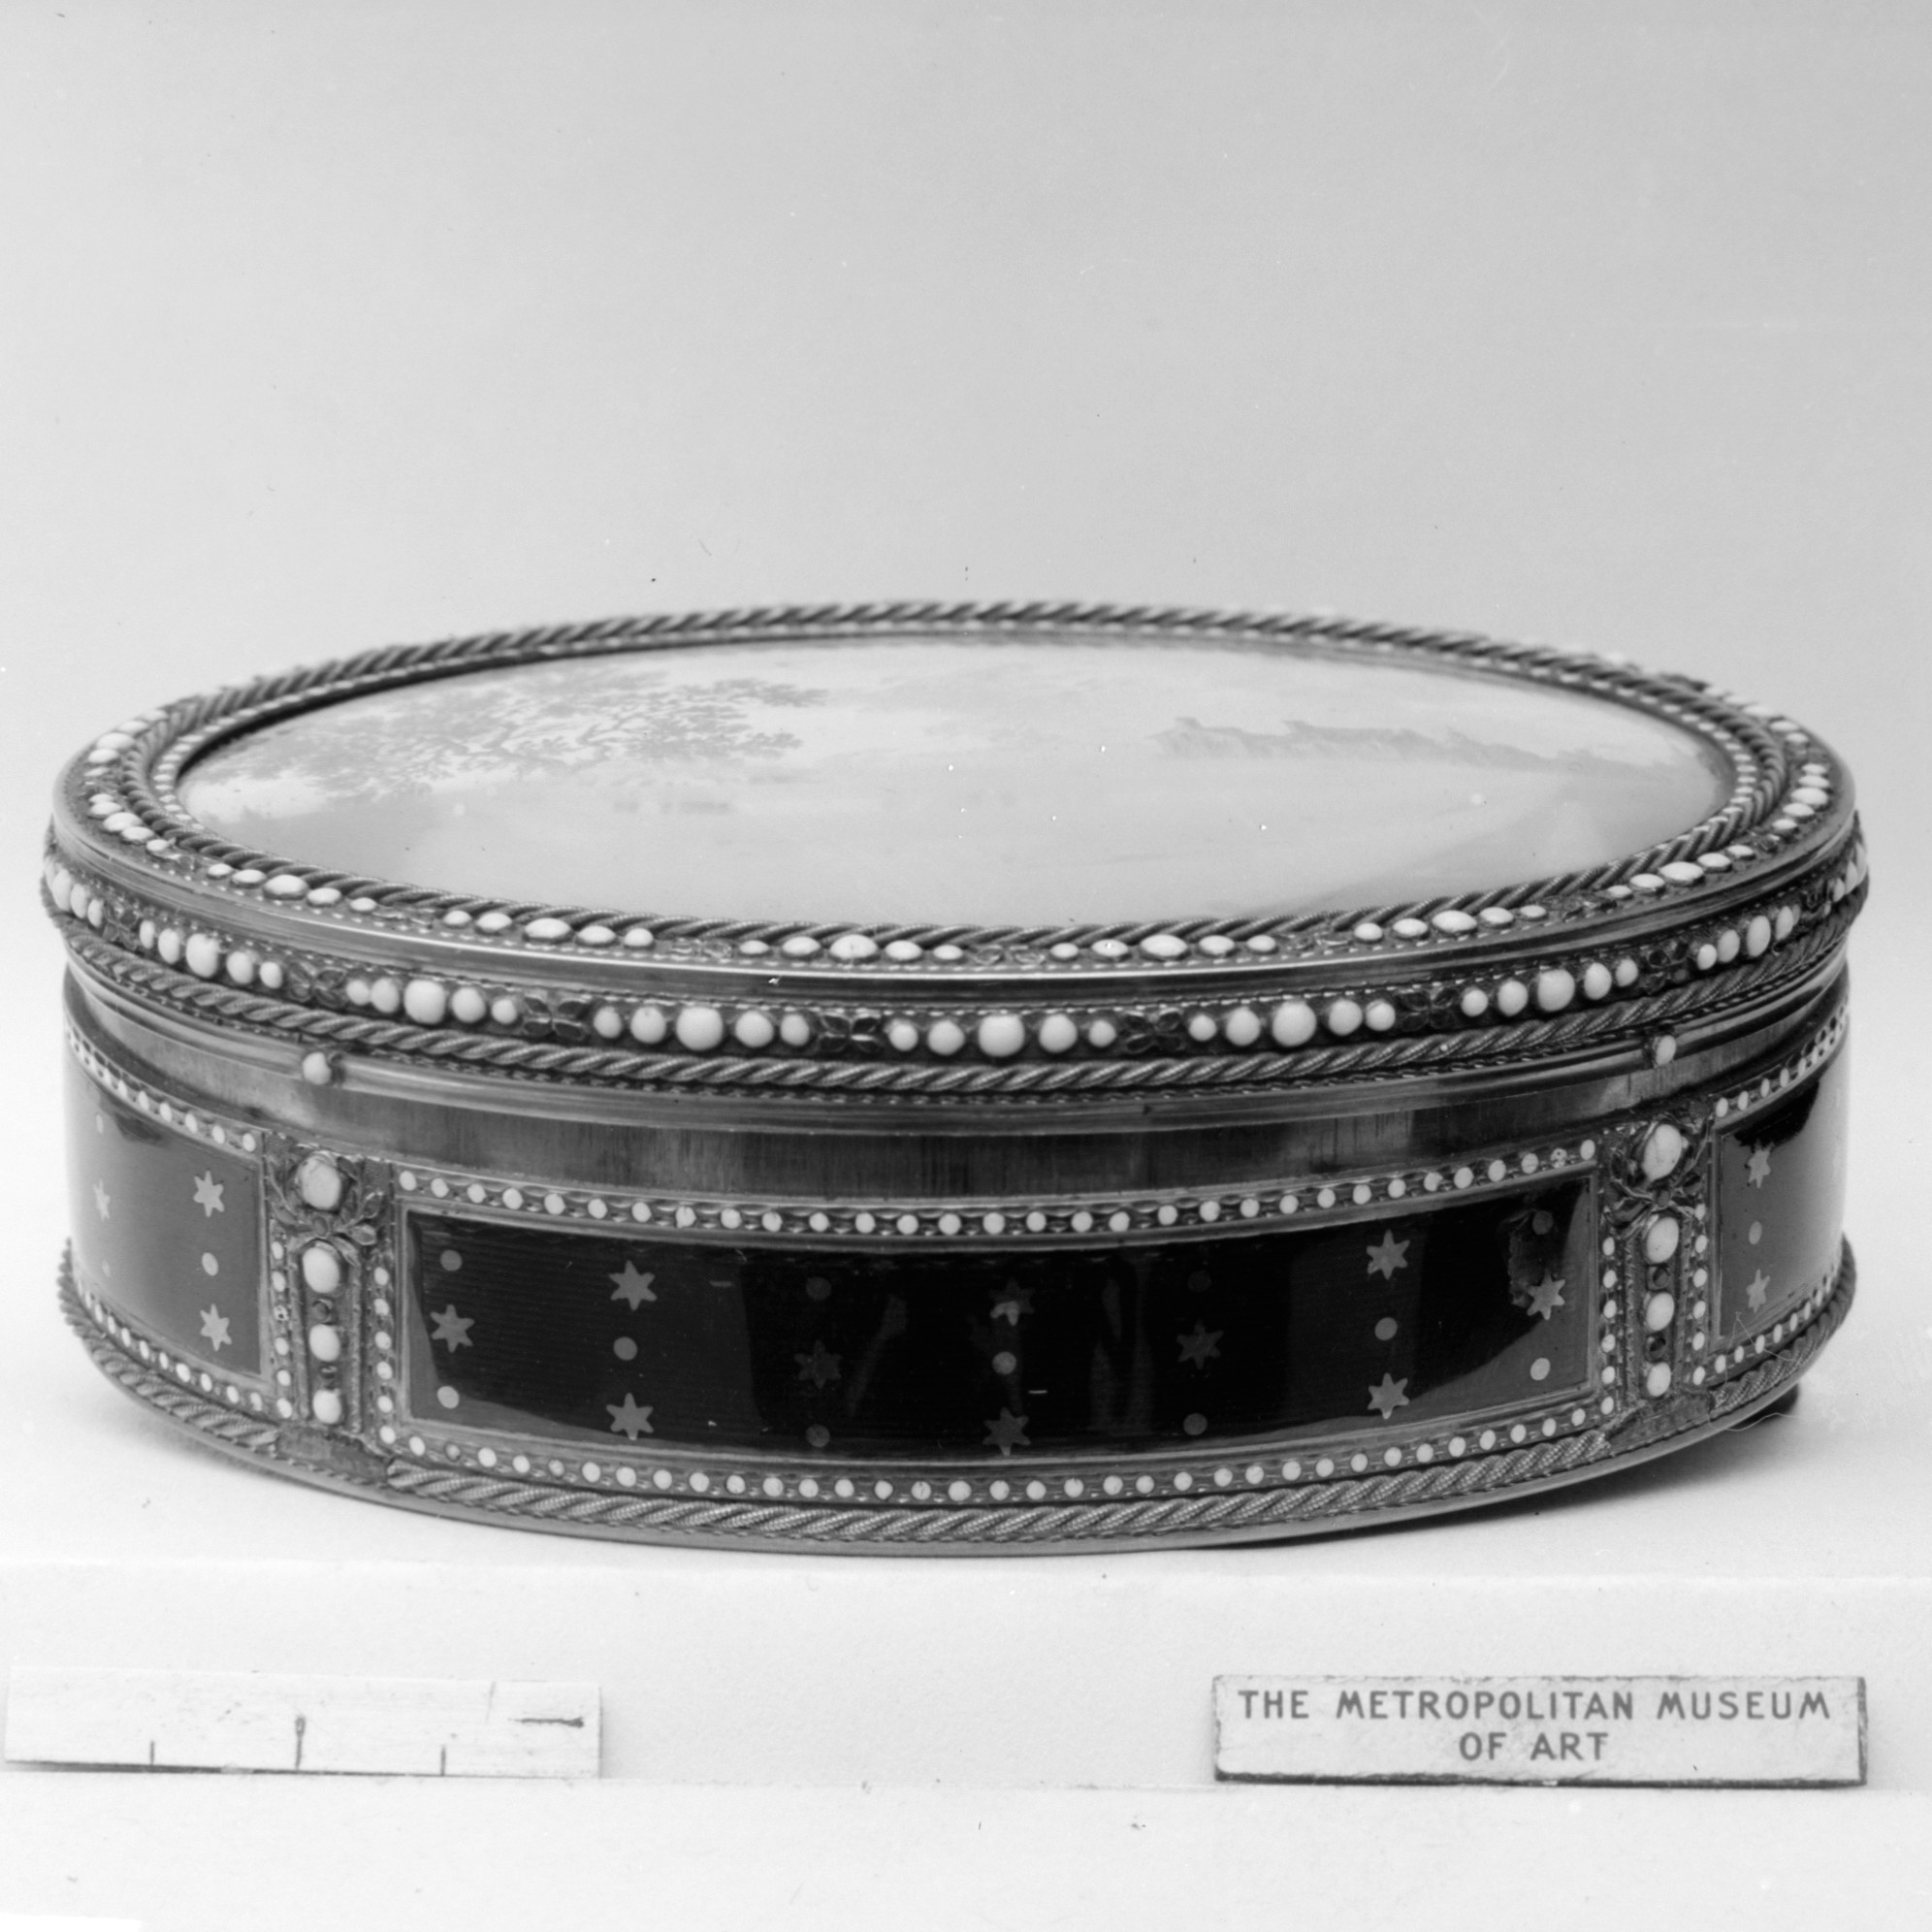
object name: snuffbox, painting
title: Snuffbox with scene of peasants picnicking on a riverbank near a village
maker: f. j., switzerland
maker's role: maker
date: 1767-1800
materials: enamel, gold, paper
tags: buildings,trees,farmers